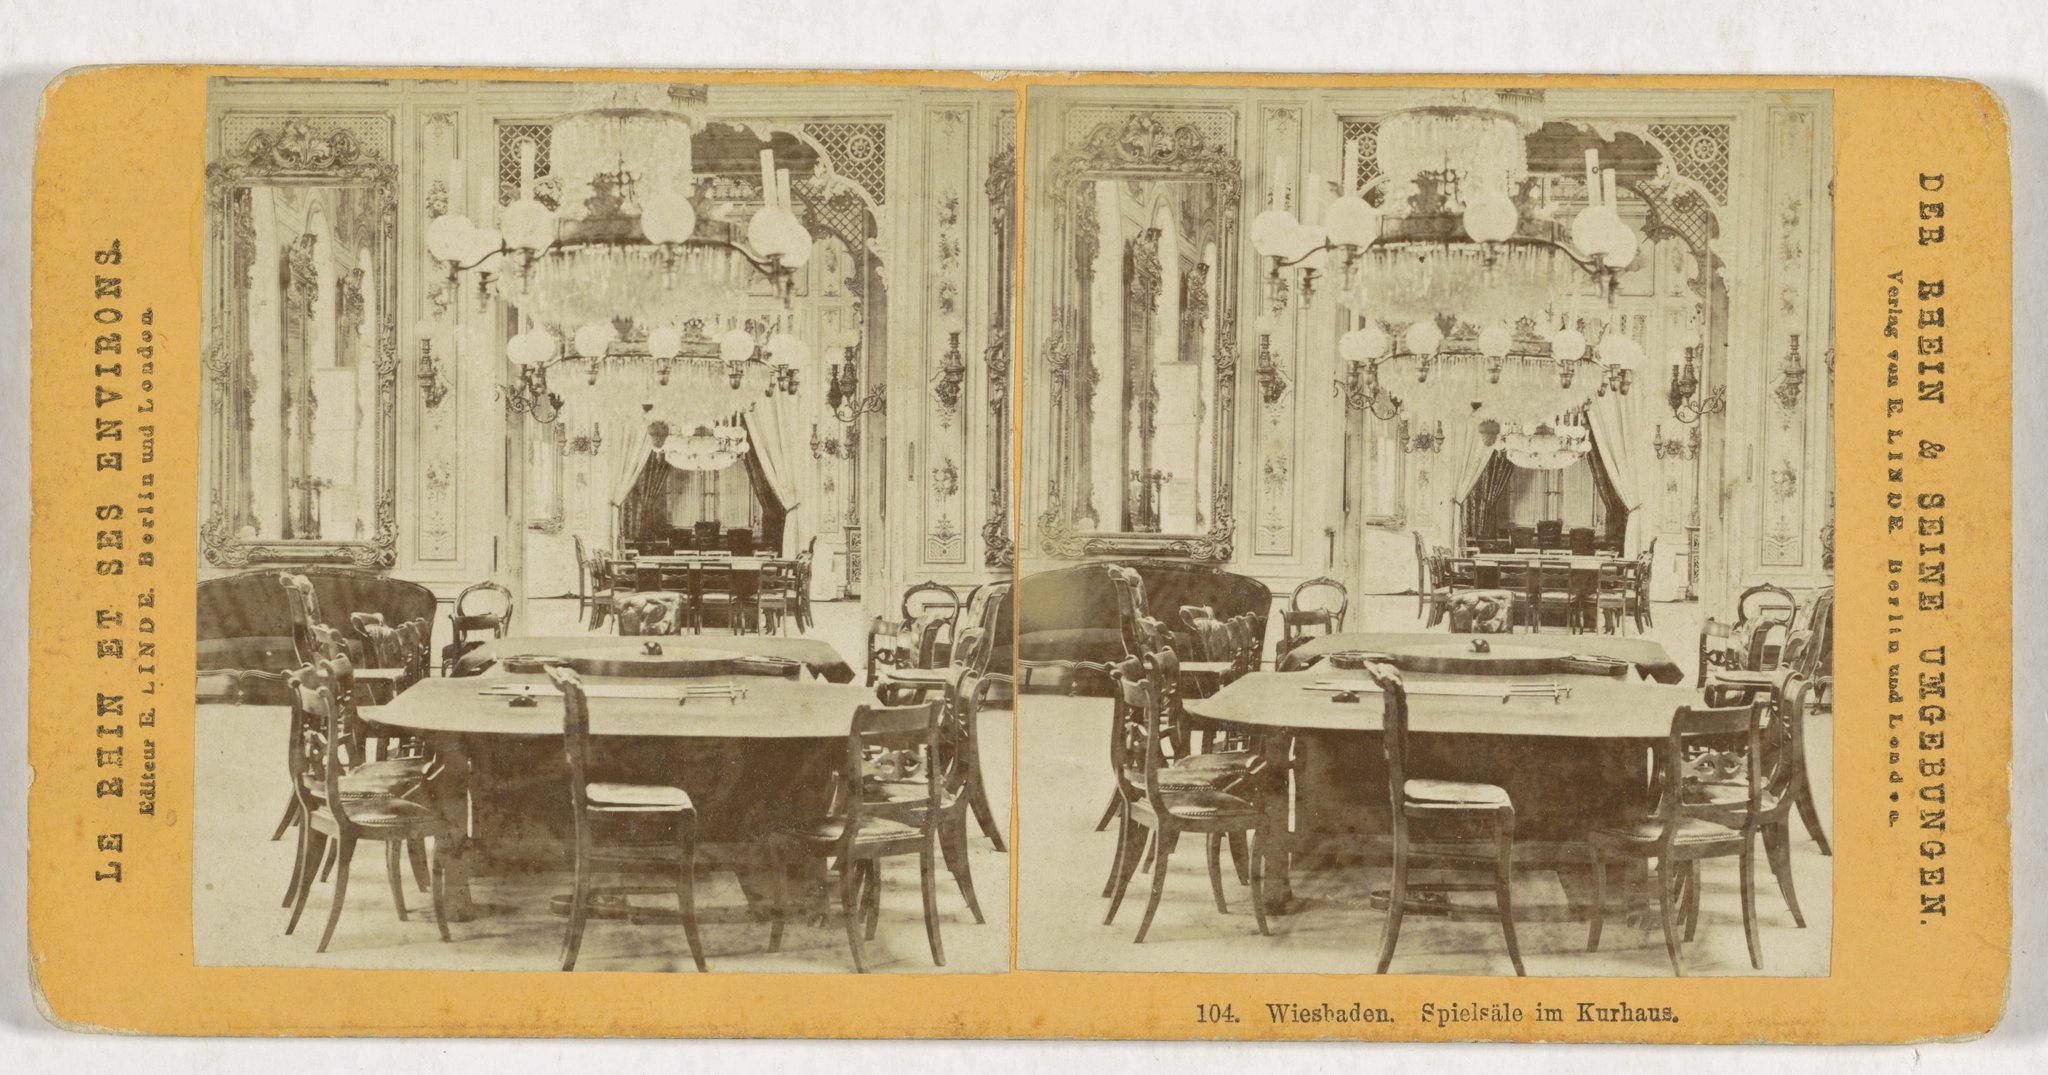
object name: stereograph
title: Der Rhein & seine Umgebung / Le Rhin & ses environs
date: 1868-1890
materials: cardboard, paper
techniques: albumen print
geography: wiesbaden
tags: casino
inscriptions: number: ‘104.’